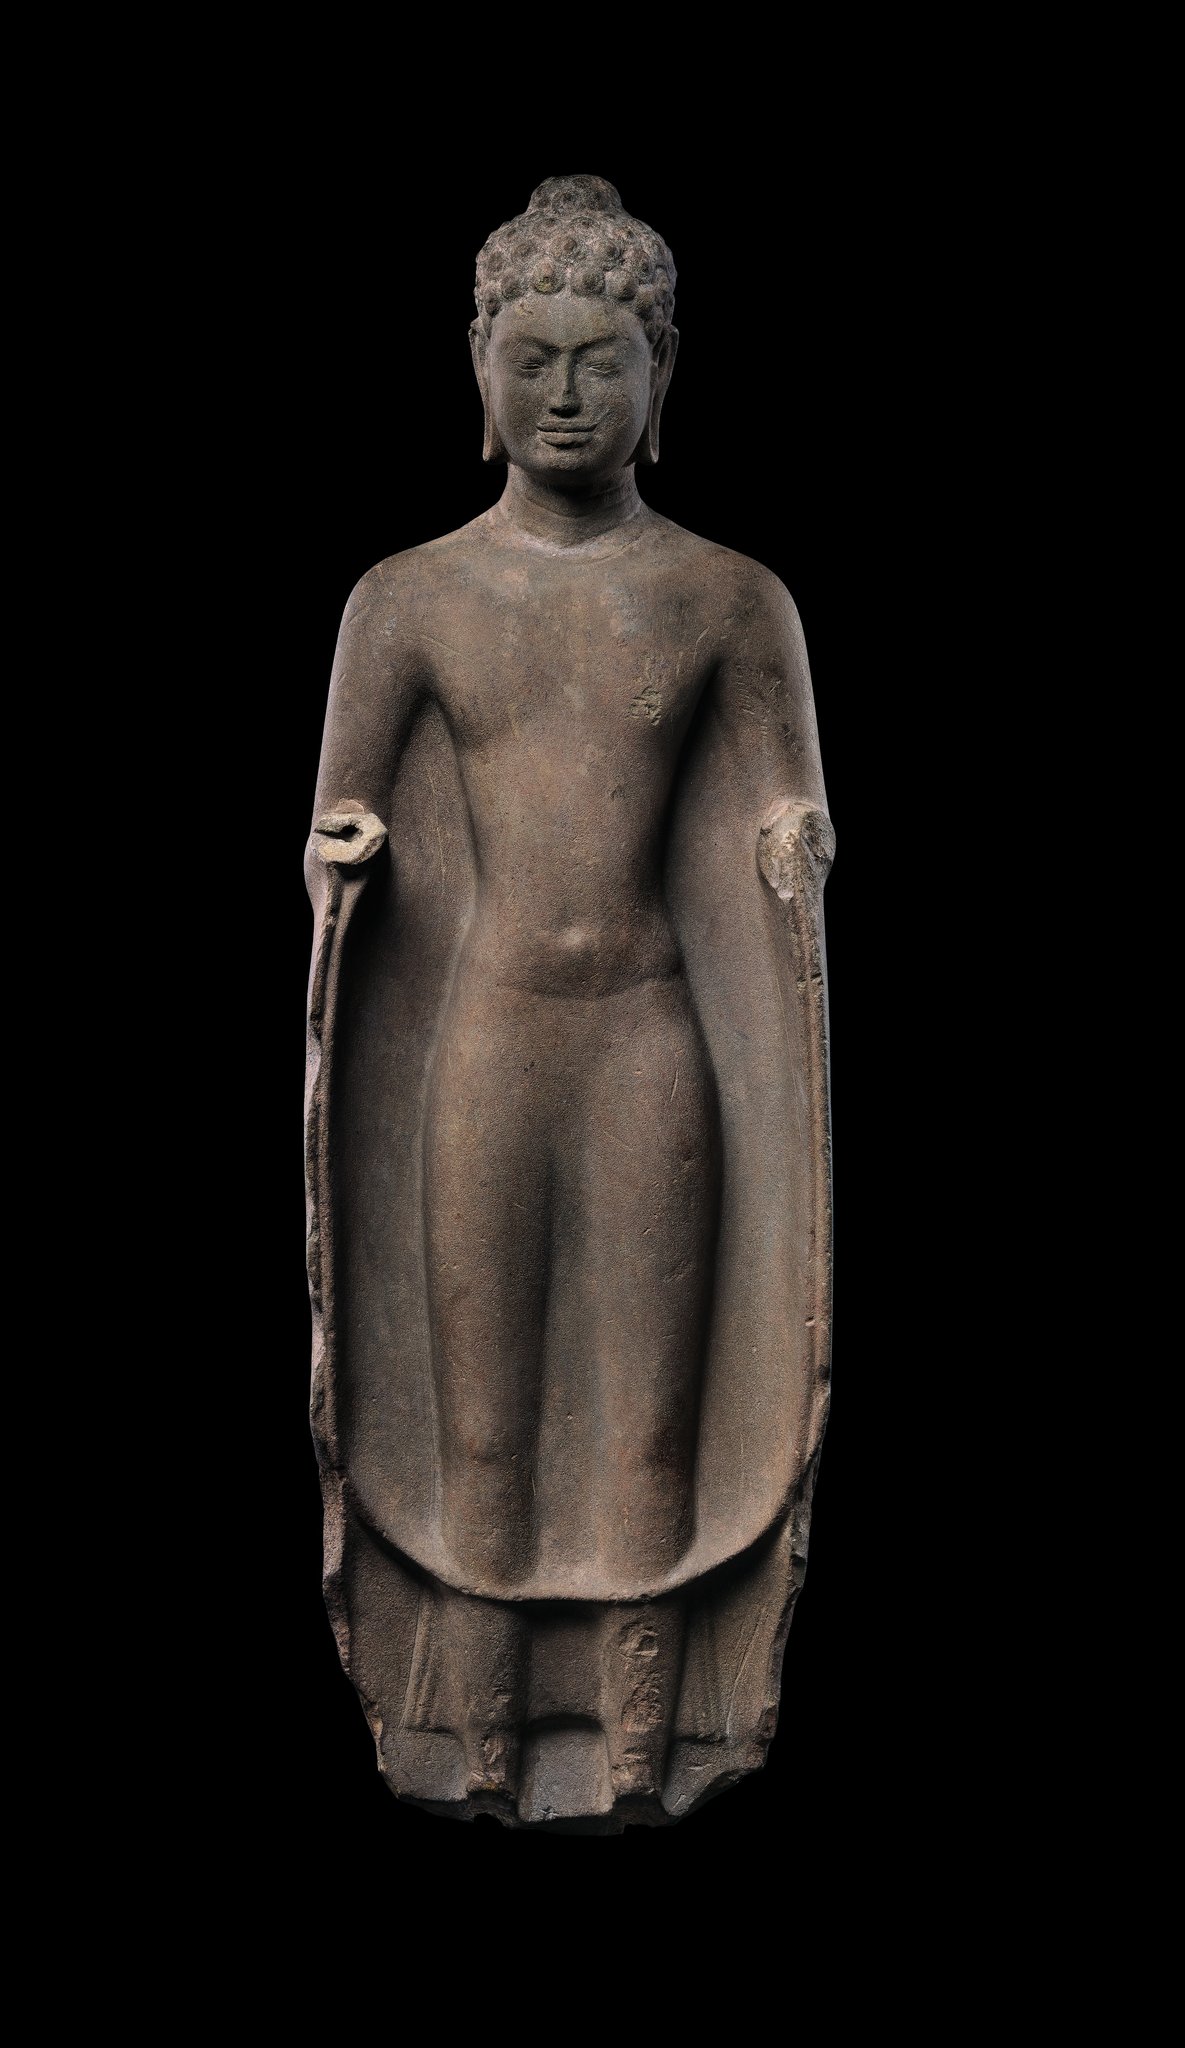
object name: figure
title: Buddha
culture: cambodian or vietnamese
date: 634-666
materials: stone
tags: buddha